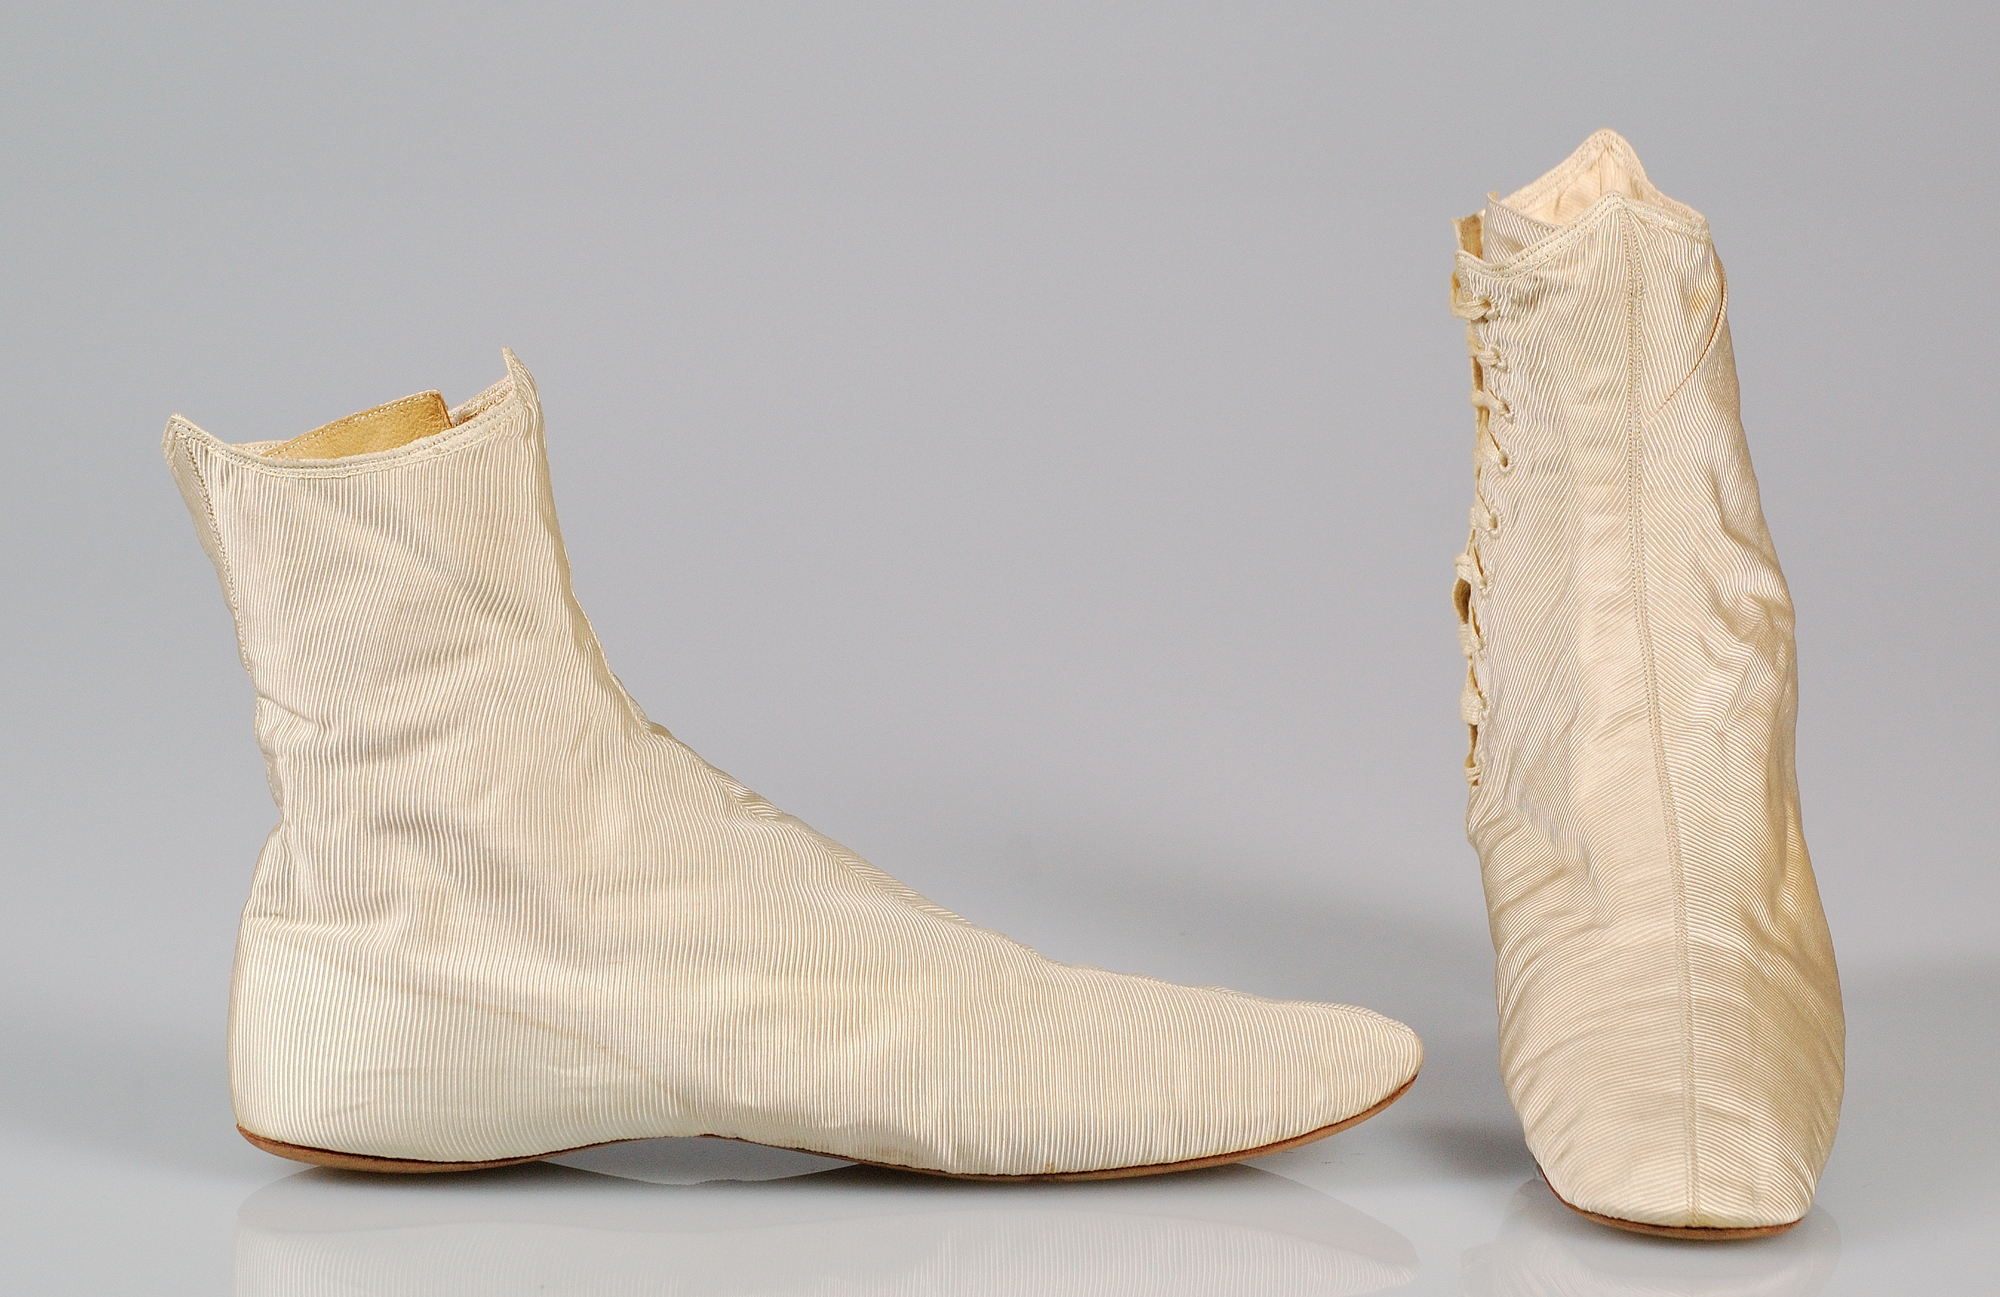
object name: wedding boot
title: Wedding boots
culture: american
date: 1855-1865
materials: silk